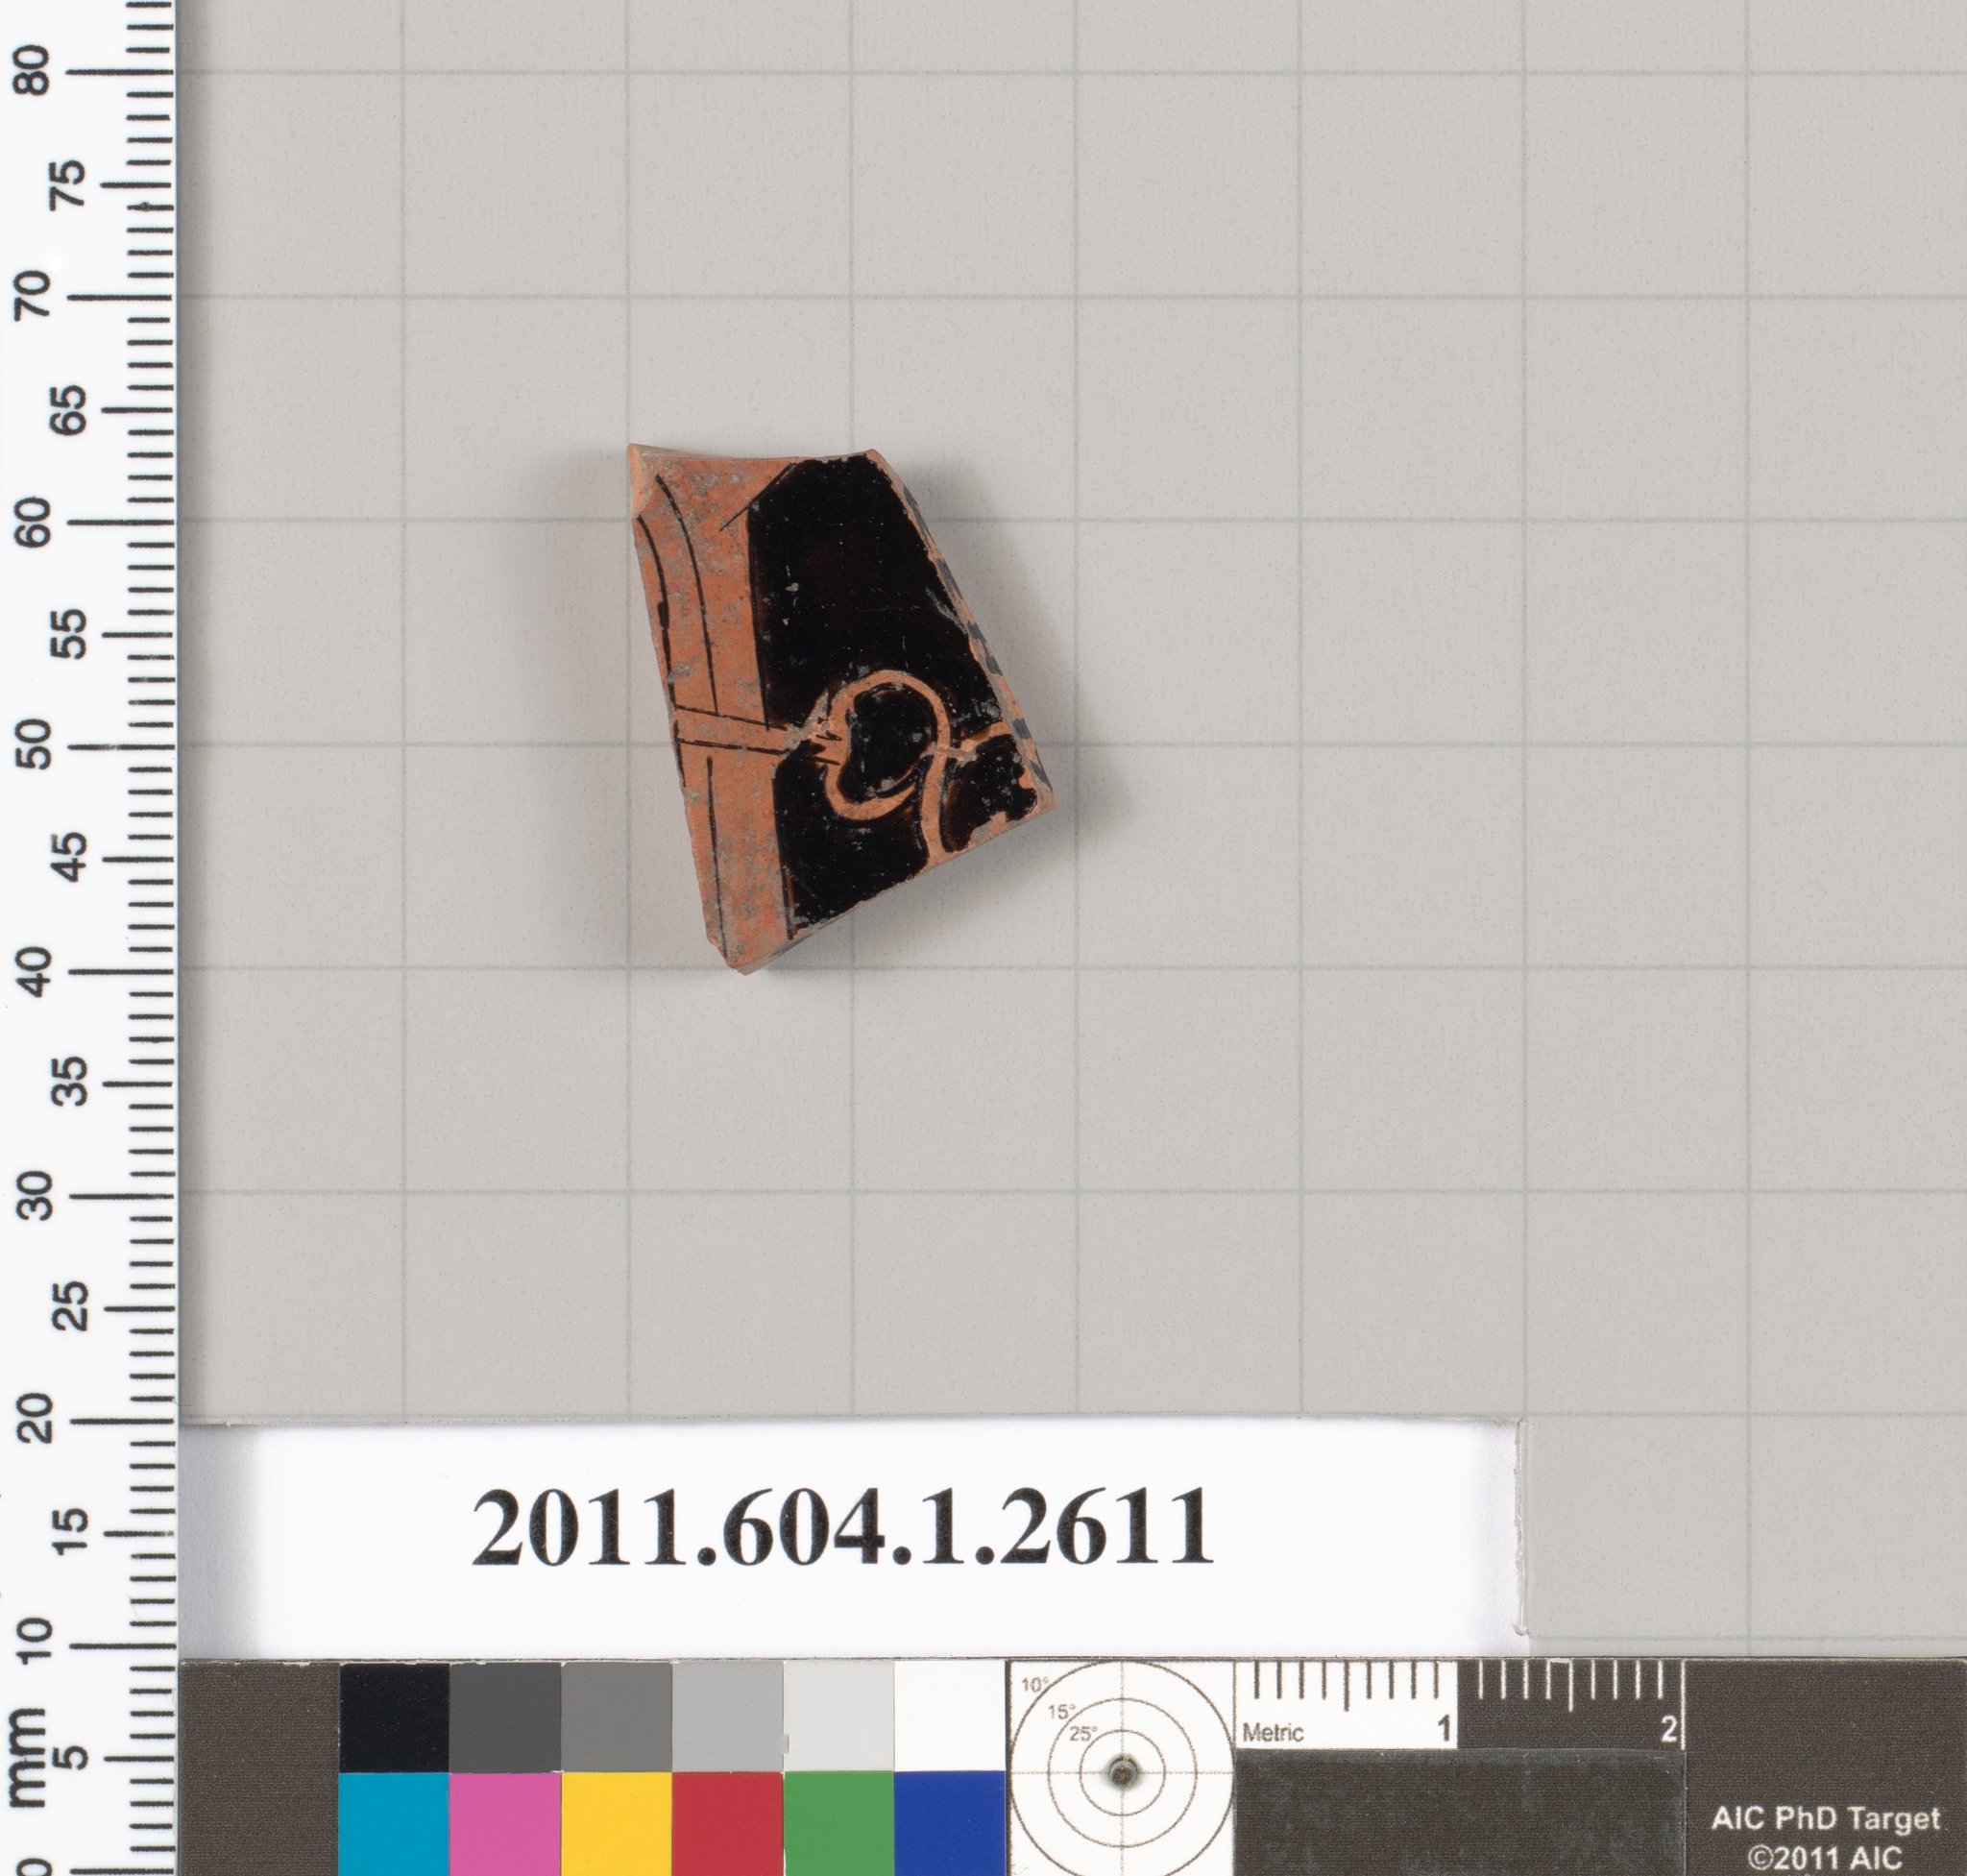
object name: kylix fragment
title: Terracotta fragment of a kylix (drinking cup)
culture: greek, attic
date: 490-480 BCE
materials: terracotta